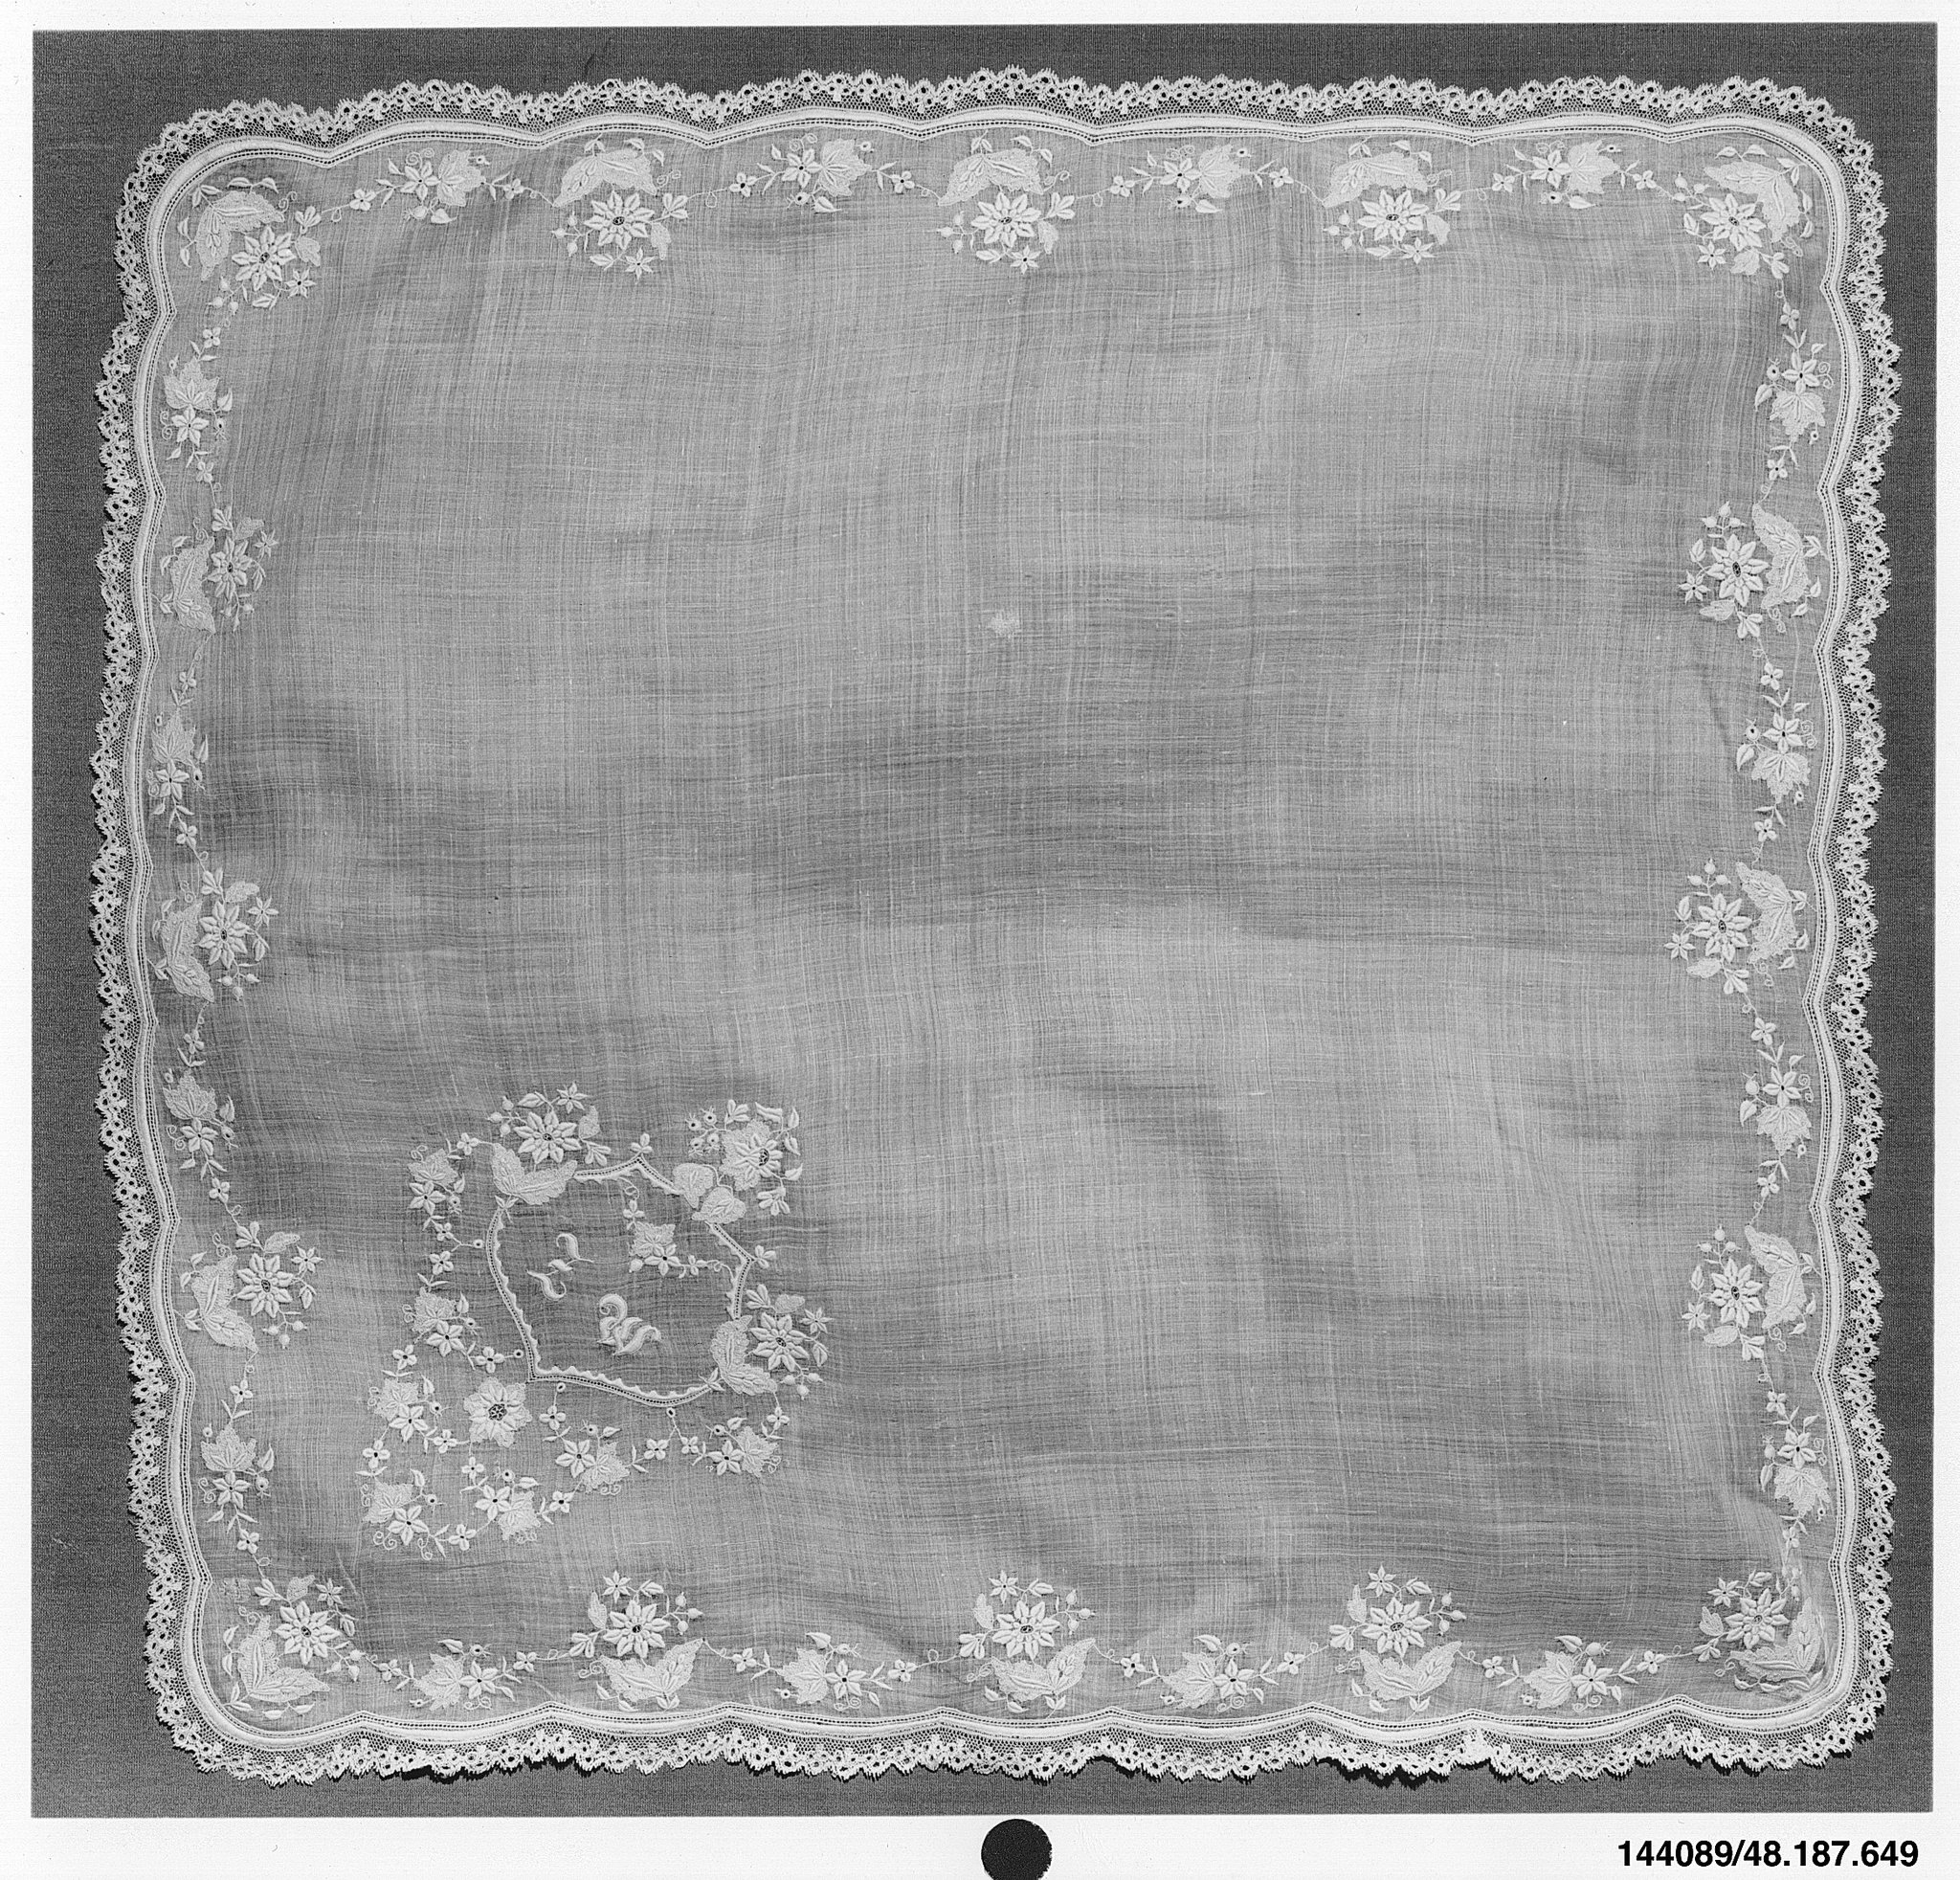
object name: handkerchief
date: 1834-1866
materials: lace, linen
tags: flowers